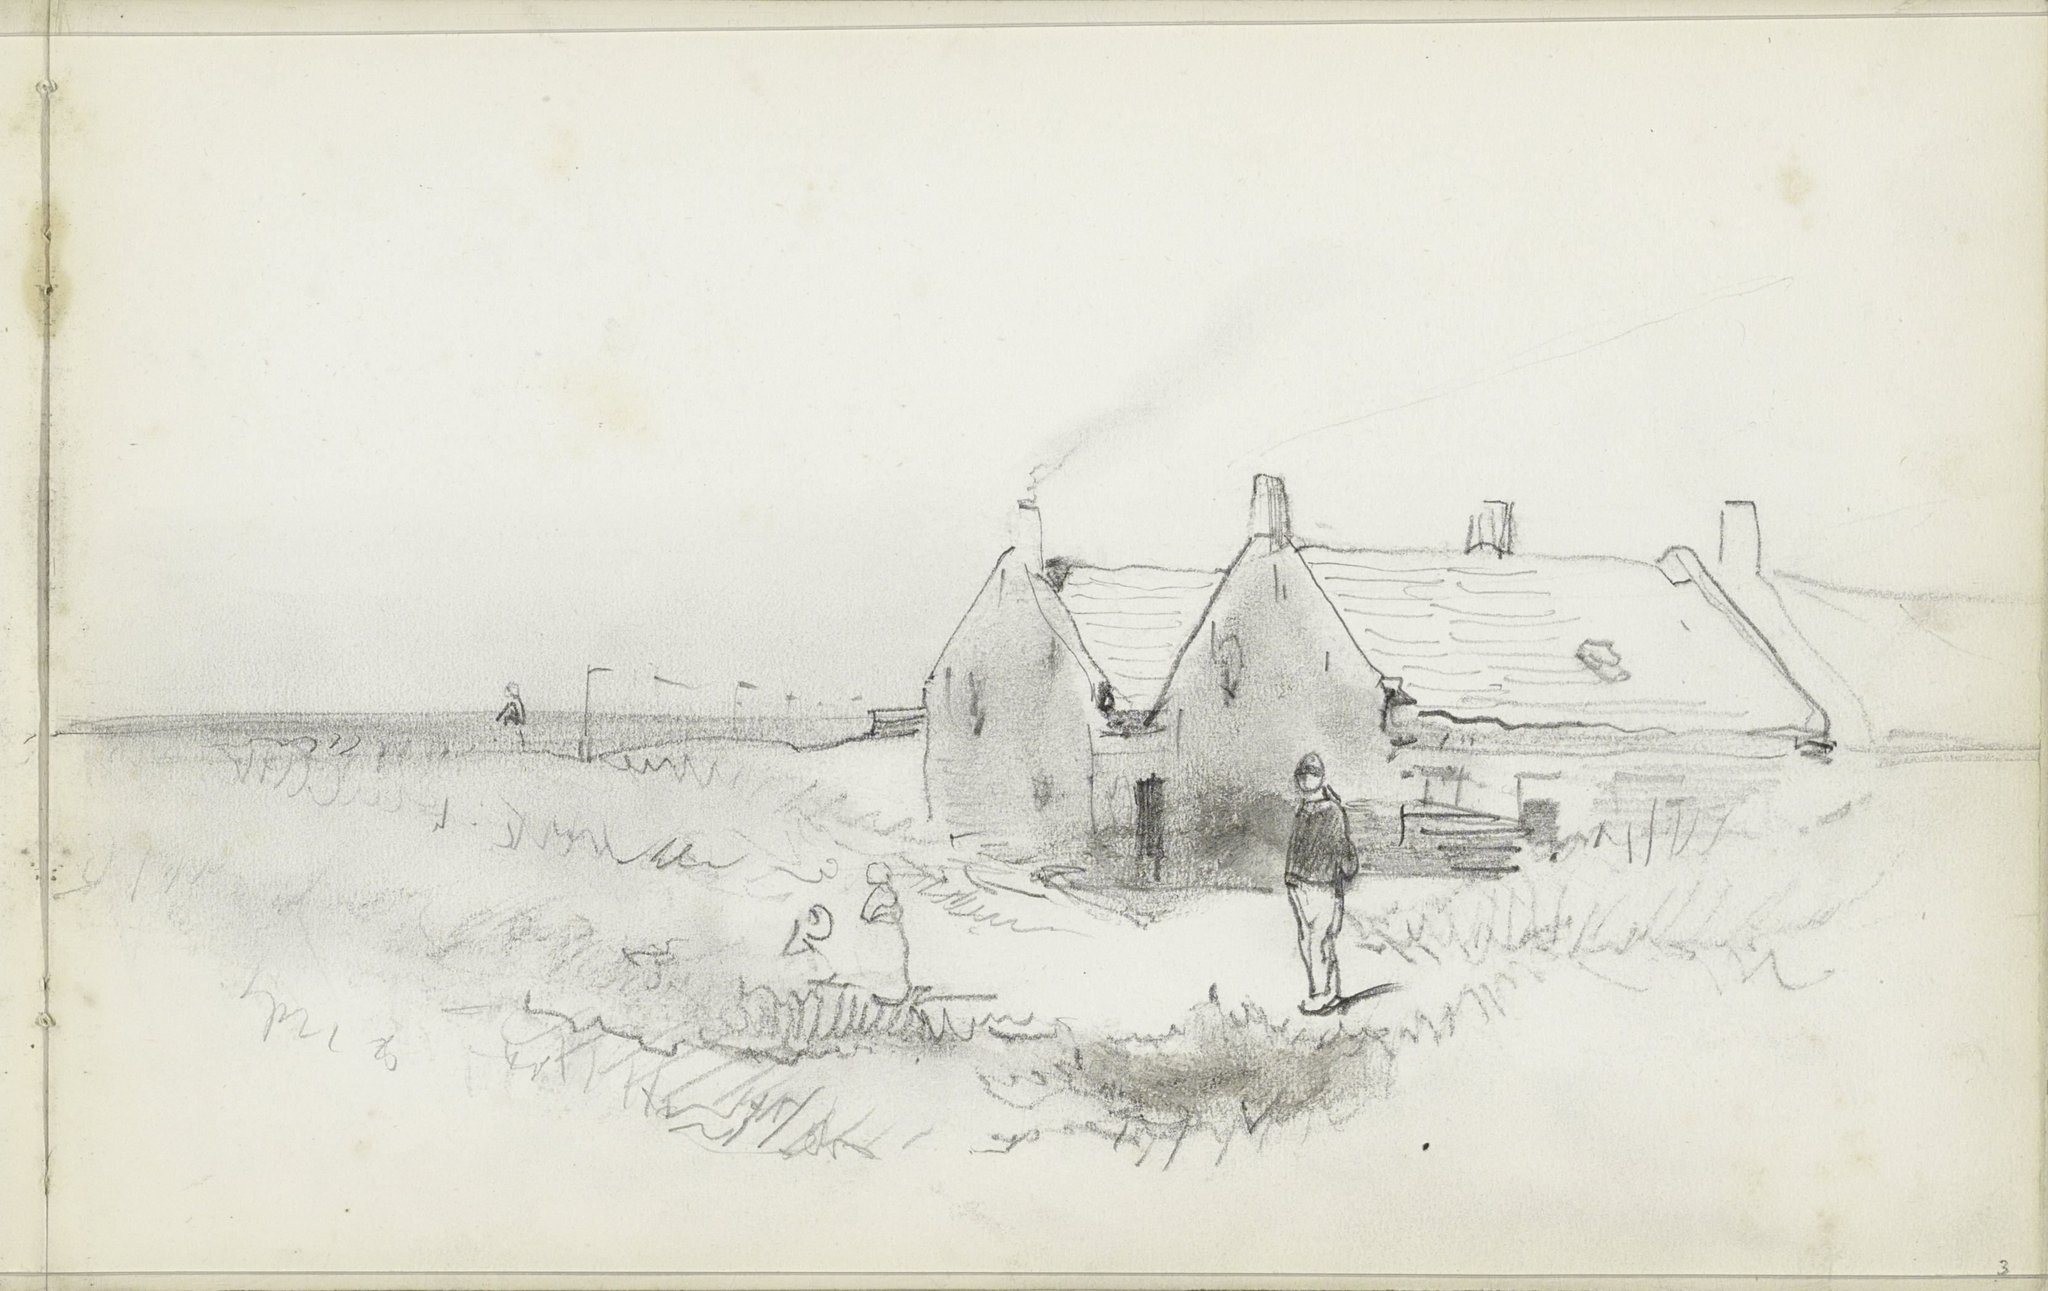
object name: sketchbook leaf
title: Figuur bij een huis in de duinen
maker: johannes bosboom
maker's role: draughtsman, painter, print maker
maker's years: 1817-1891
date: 1873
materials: chalk, paper, pencil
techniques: brush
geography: scheveningen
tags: rural housing, e.g. country-house, villa, cottage, dune coast (+ landscape with figures, staffage)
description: Op de achtergrond zijn vlaggen van scheepsmasten en de zee te zien. Blad 3 recto uit een schetsboek met 39 bladen.